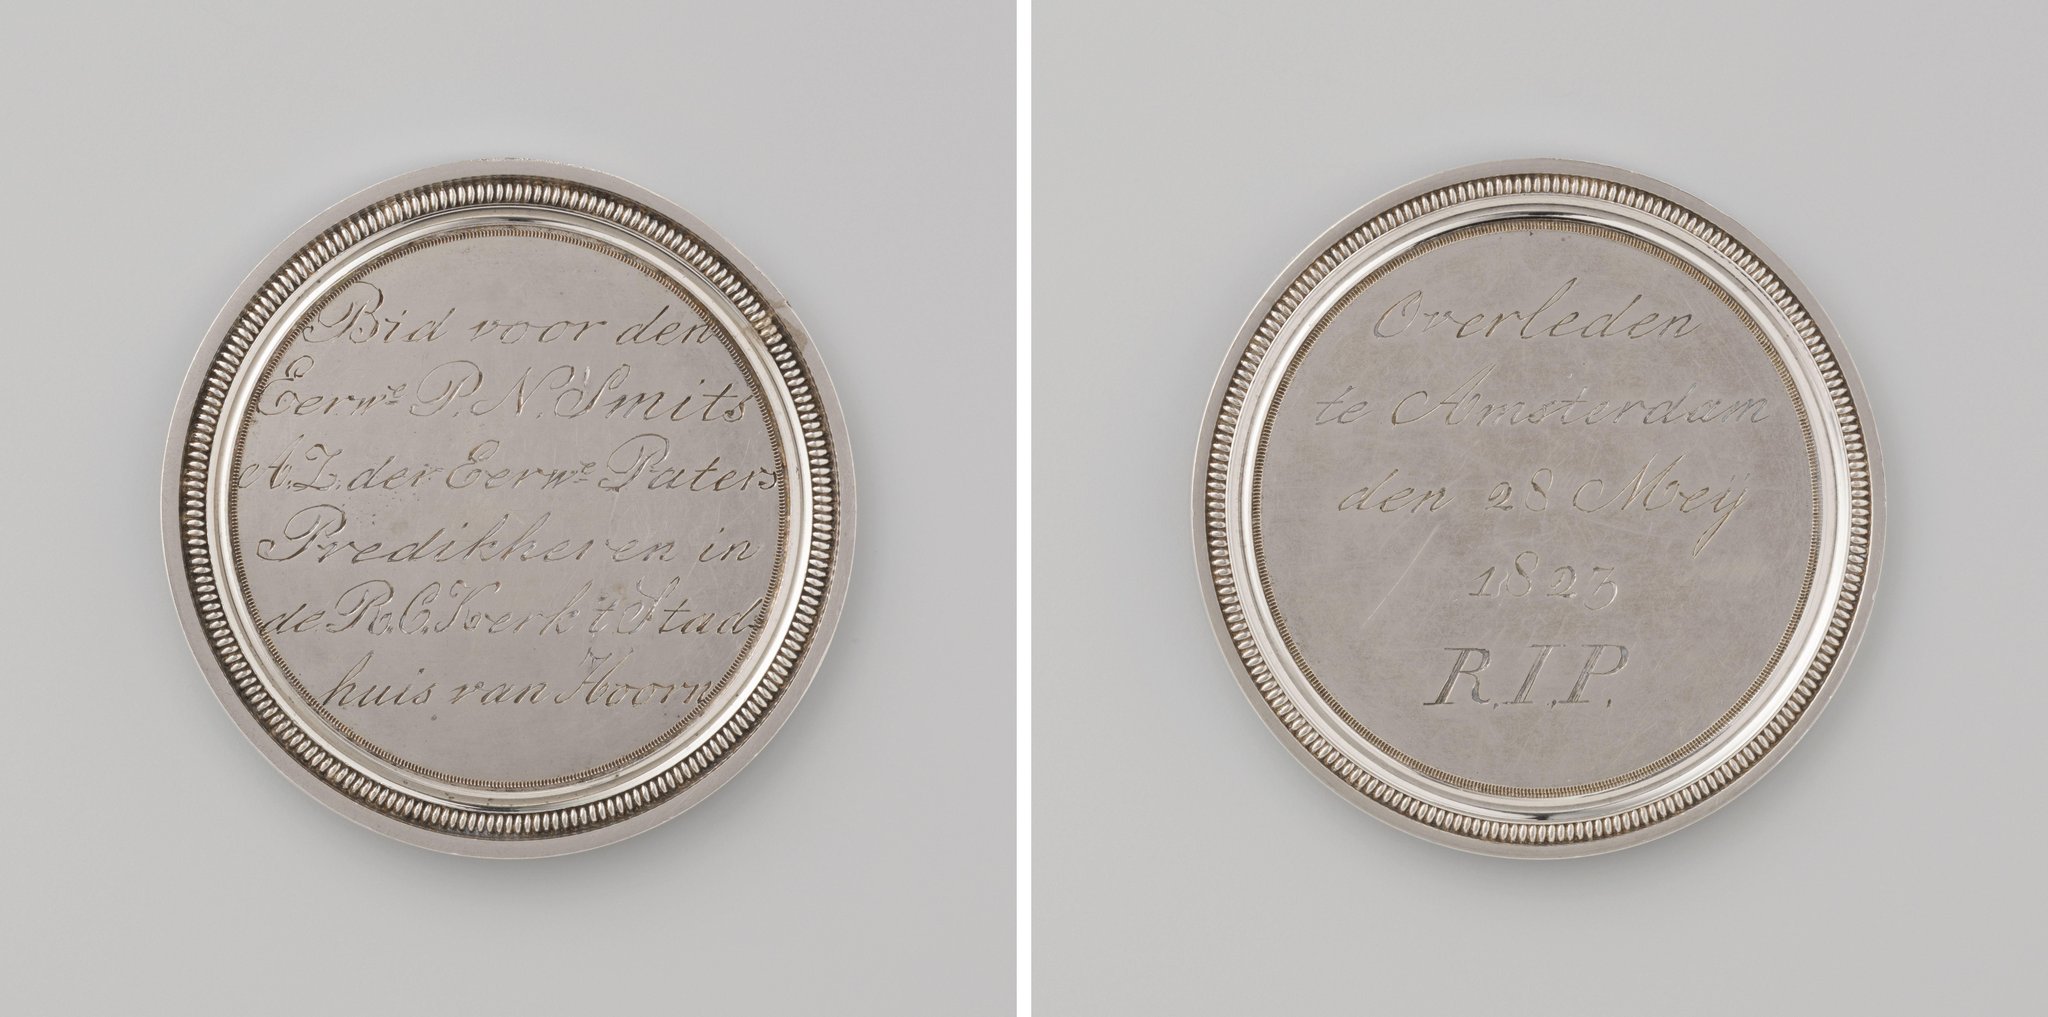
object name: family medal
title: Overlijden van P.N. Smits Az. der paters-predikheren in de kerk 't Stadhuis van Hoorn te Amsterdam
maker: Anonymous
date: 1823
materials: silver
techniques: engraving, striking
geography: netherlands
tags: amsterdam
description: Zilveren penning. Voorzijde: opschrift binnen kabelrand. Keerzijde: opschrift binnen kabelrand.